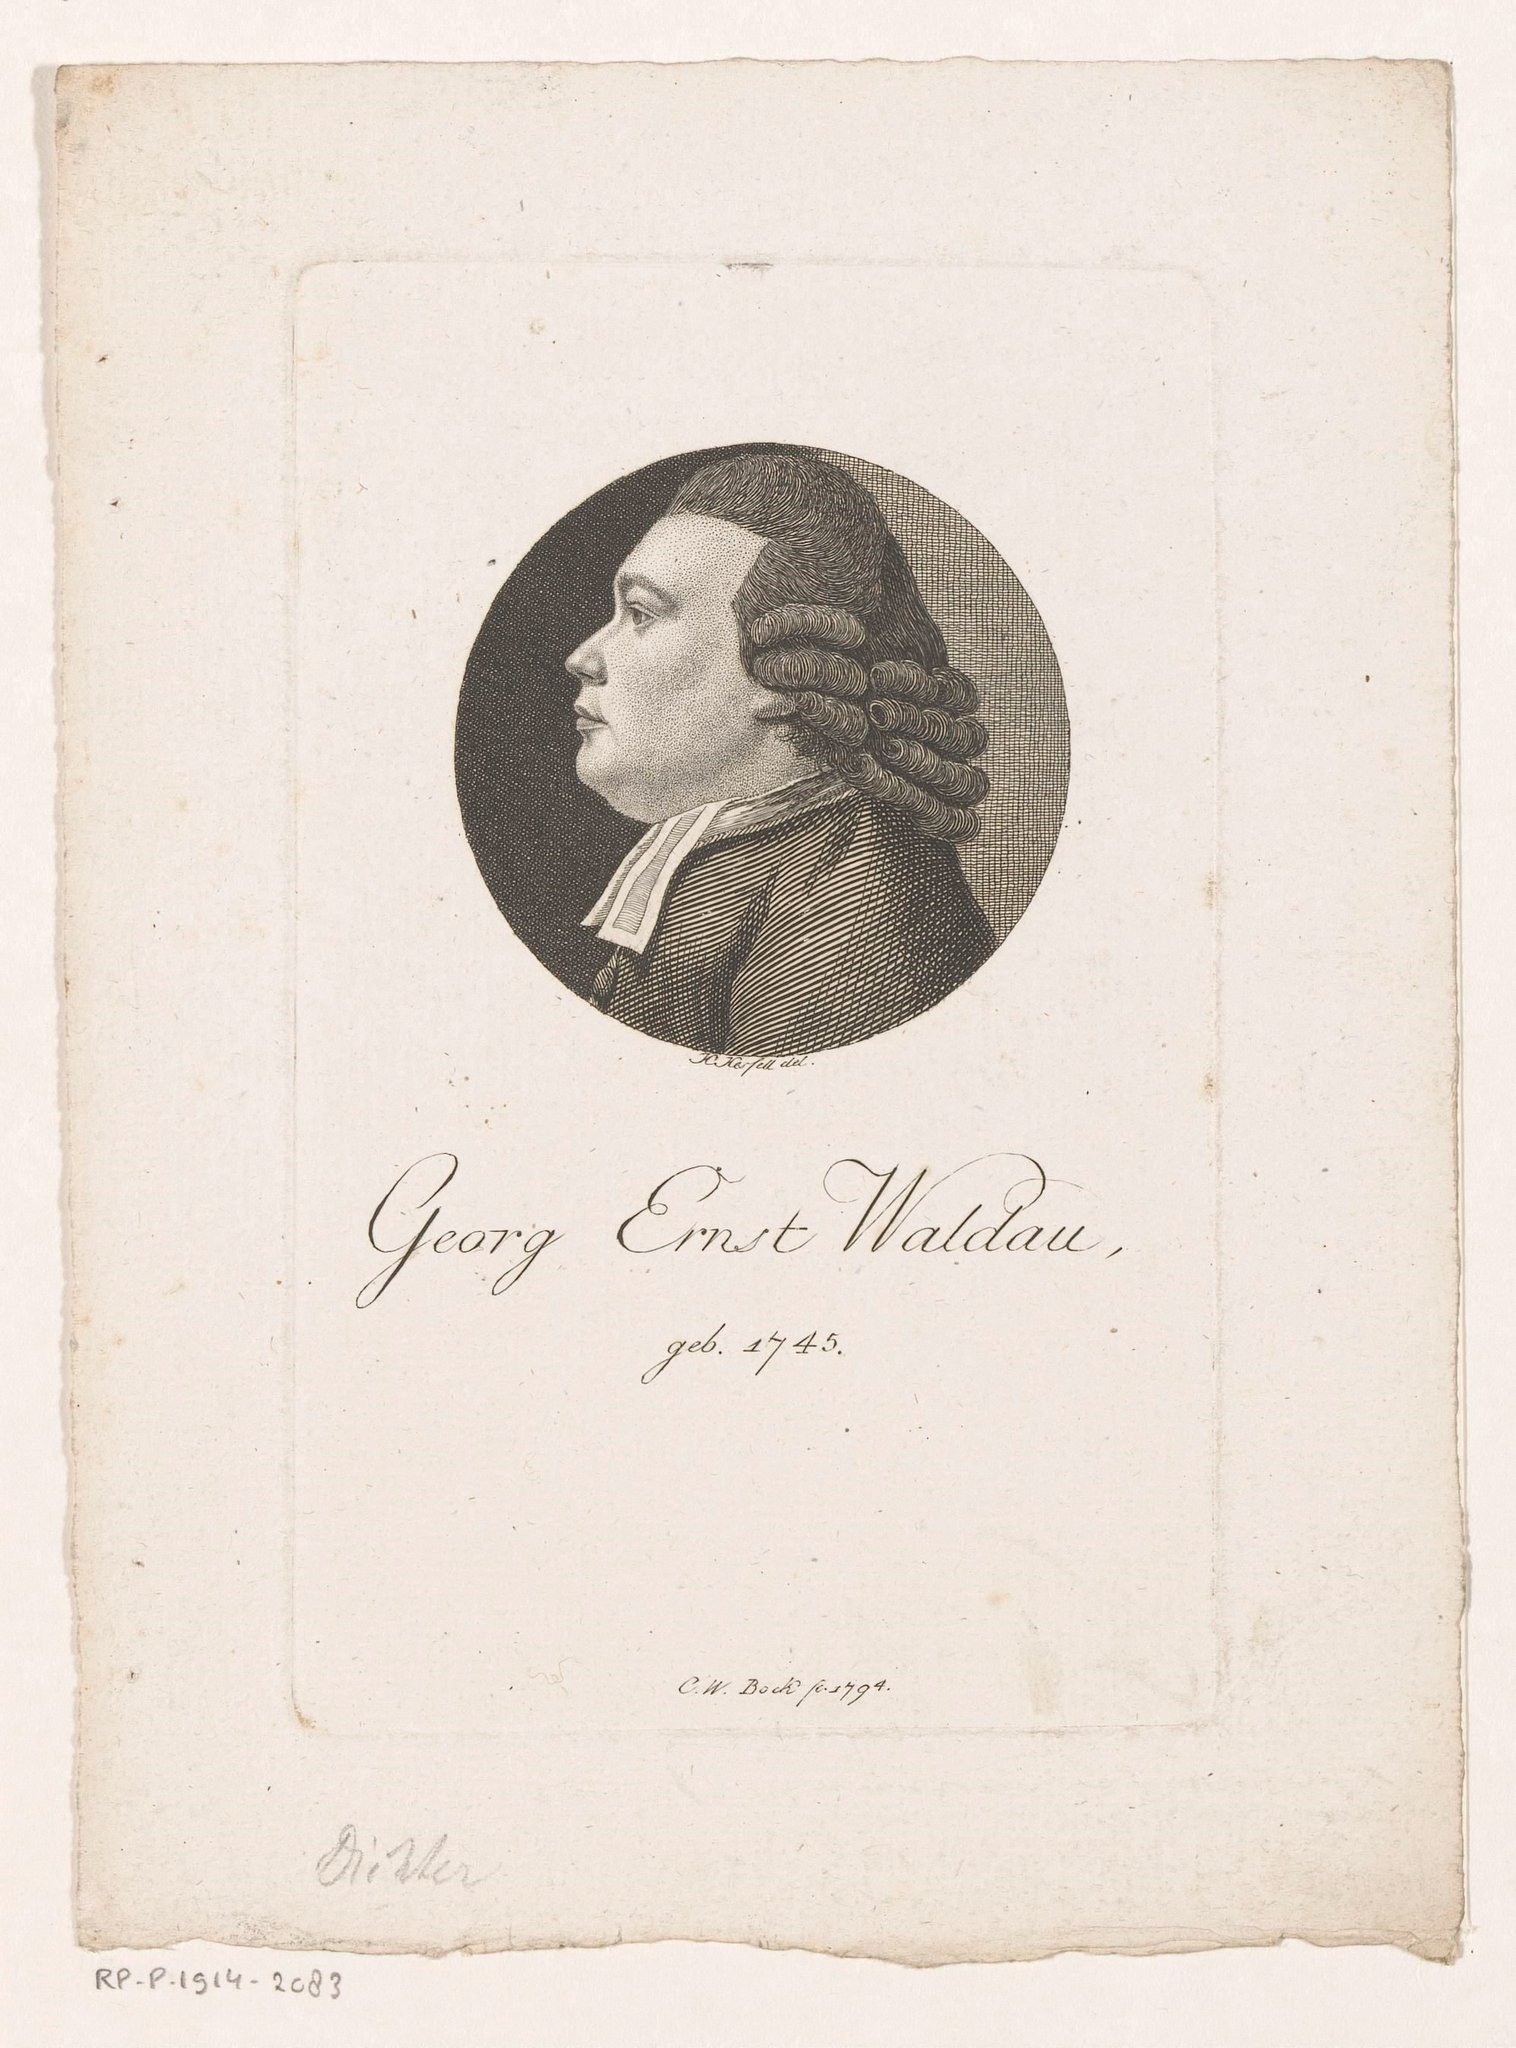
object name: print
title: Portret van Georg Ernst Waldau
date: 1794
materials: paper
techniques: engraving, etching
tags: historical persons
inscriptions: collector's mark: Lugt 2228